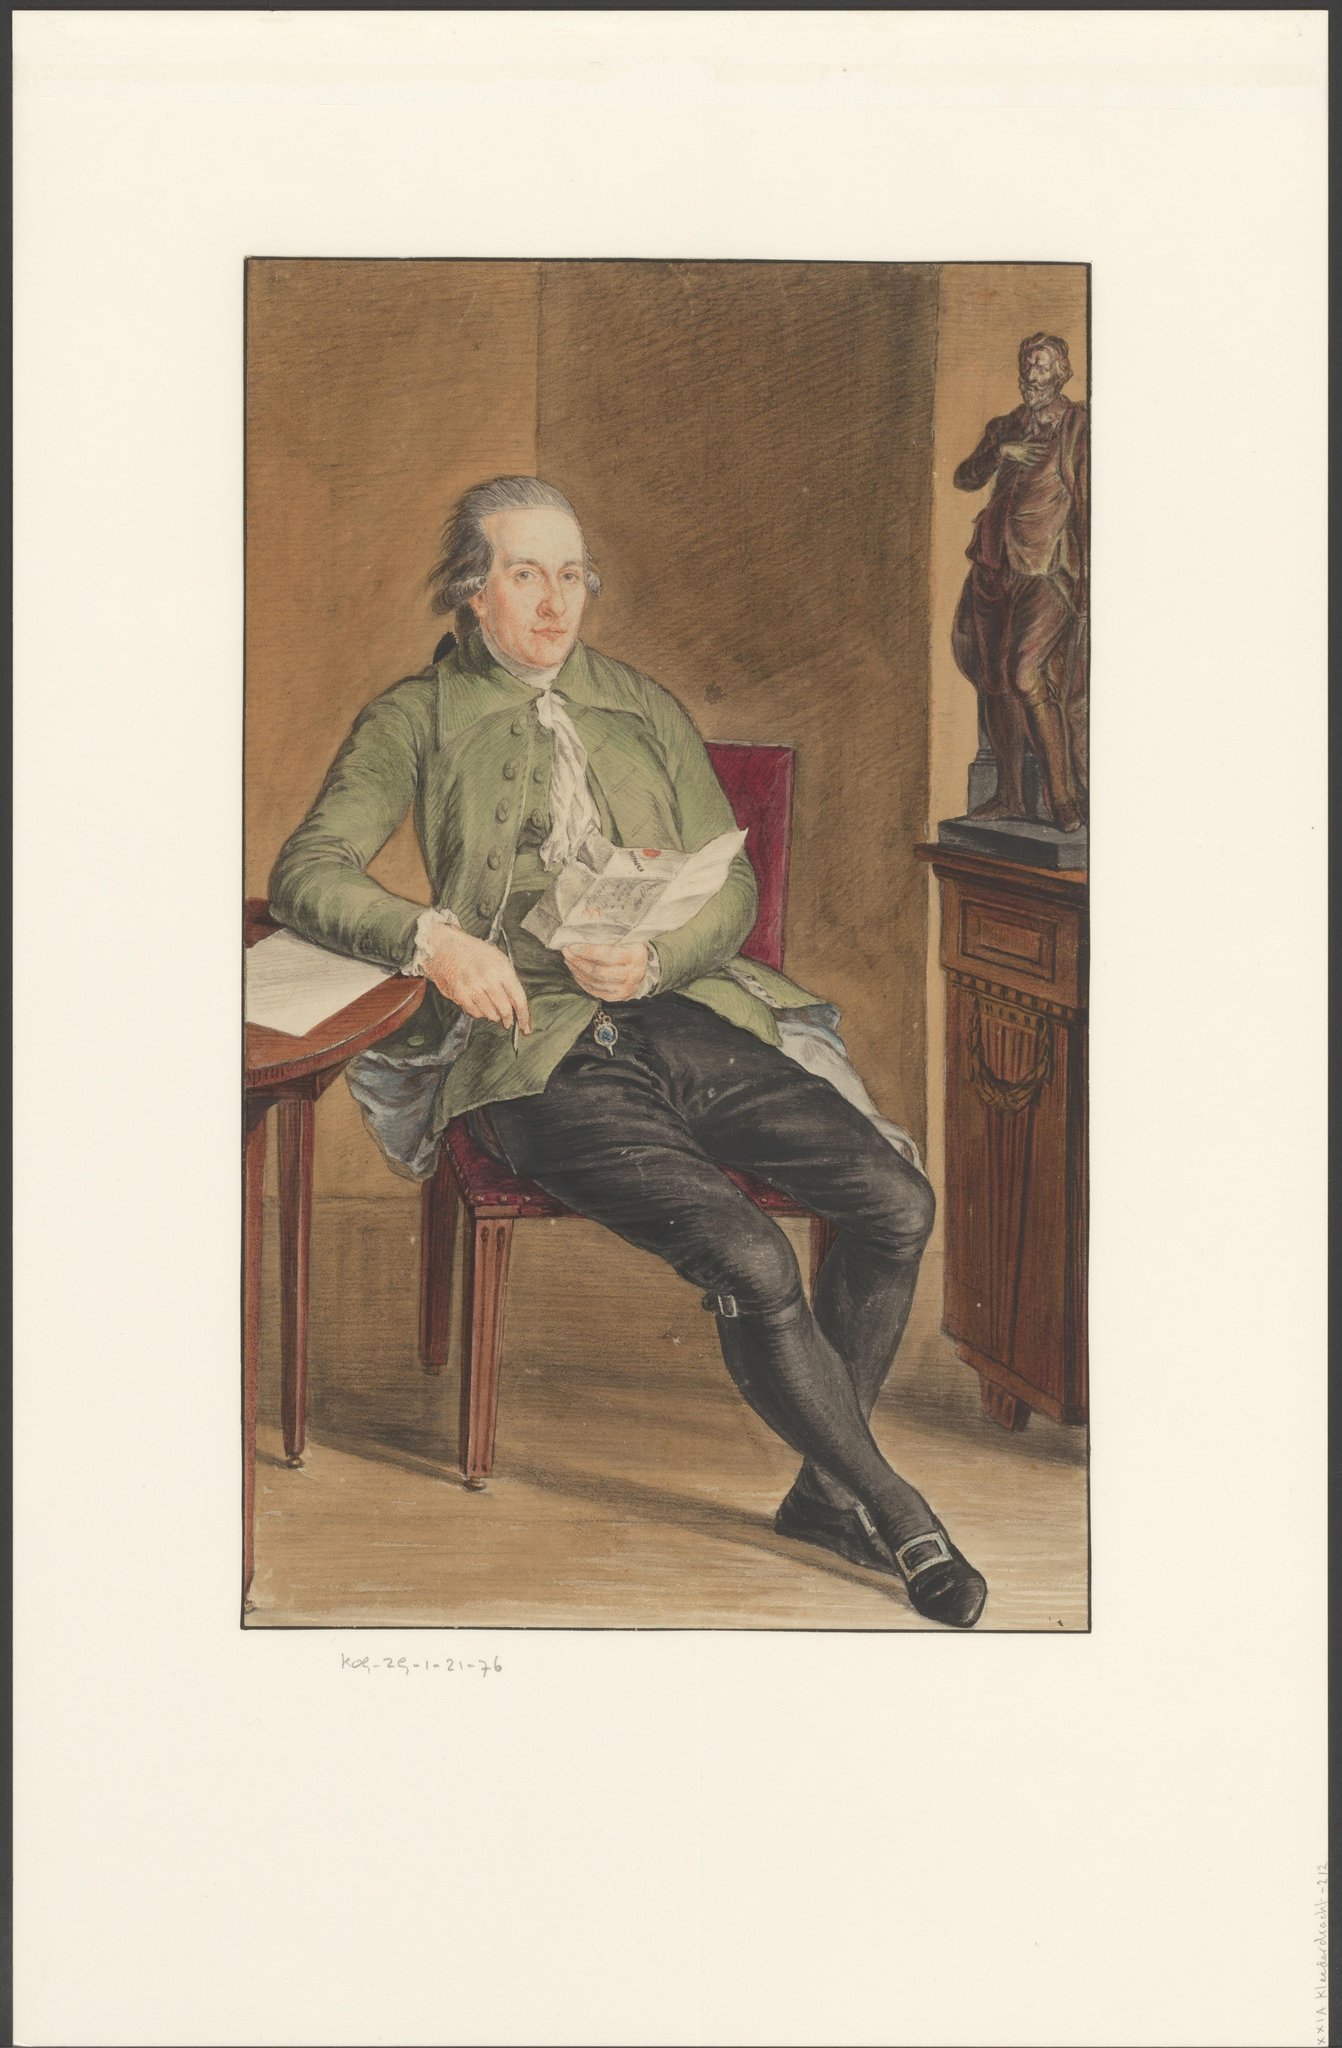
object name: drawing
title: Brieflezende man aan een tafel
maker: Anonymous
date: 1729-1773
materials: chalk, paper, watercolor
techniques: brush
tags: sitting figure, monument, statue, coat, cape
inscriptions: collector's mark: Lugt 1641, stamp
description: Onderwerpsrubrieken binnen de Atlas Zeden en Gewoonten: Zeden en Gewoonten in Engeren Zin, De Kleeding, Kleederdrachten (tijdvakken), De 18de eeuw (de pruikentijd). Mannen en vrouwen.